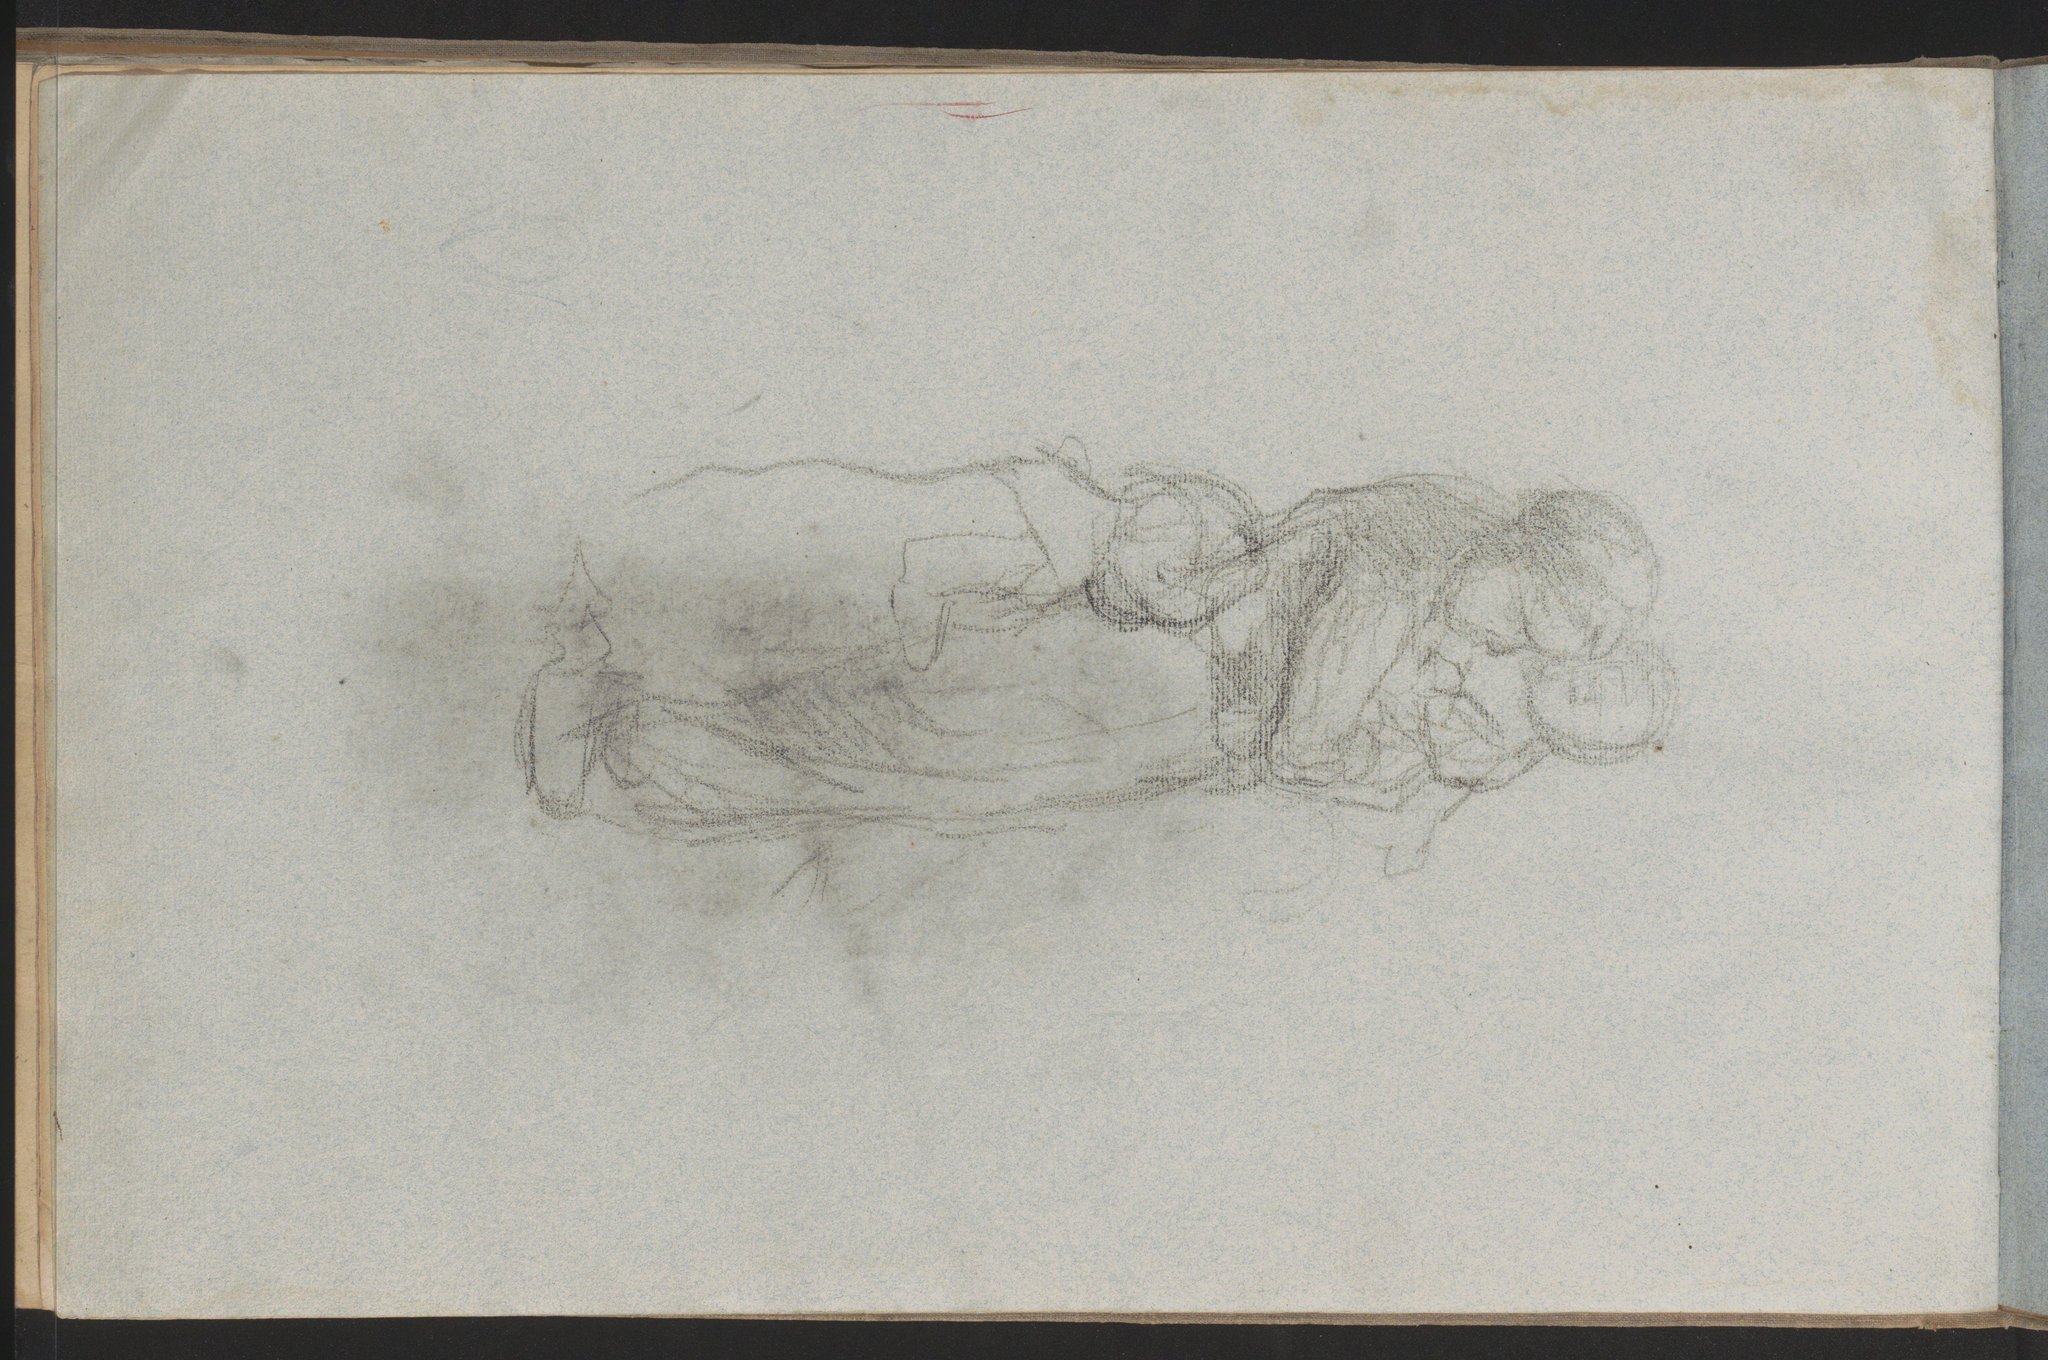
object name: sketchbook leaf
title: Moeder met een kind en een baby op de arm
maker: albert neuhuys (1844-1914)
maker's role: draughtsman, painter, print maker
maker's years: 1844-1914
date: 1854-1914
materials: charcoal, paper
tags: other methods of carrying children, mother and child(ren), woman and child(ren) (family group)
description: Blad 40 verso uit een schetsboek met 51 bladen.